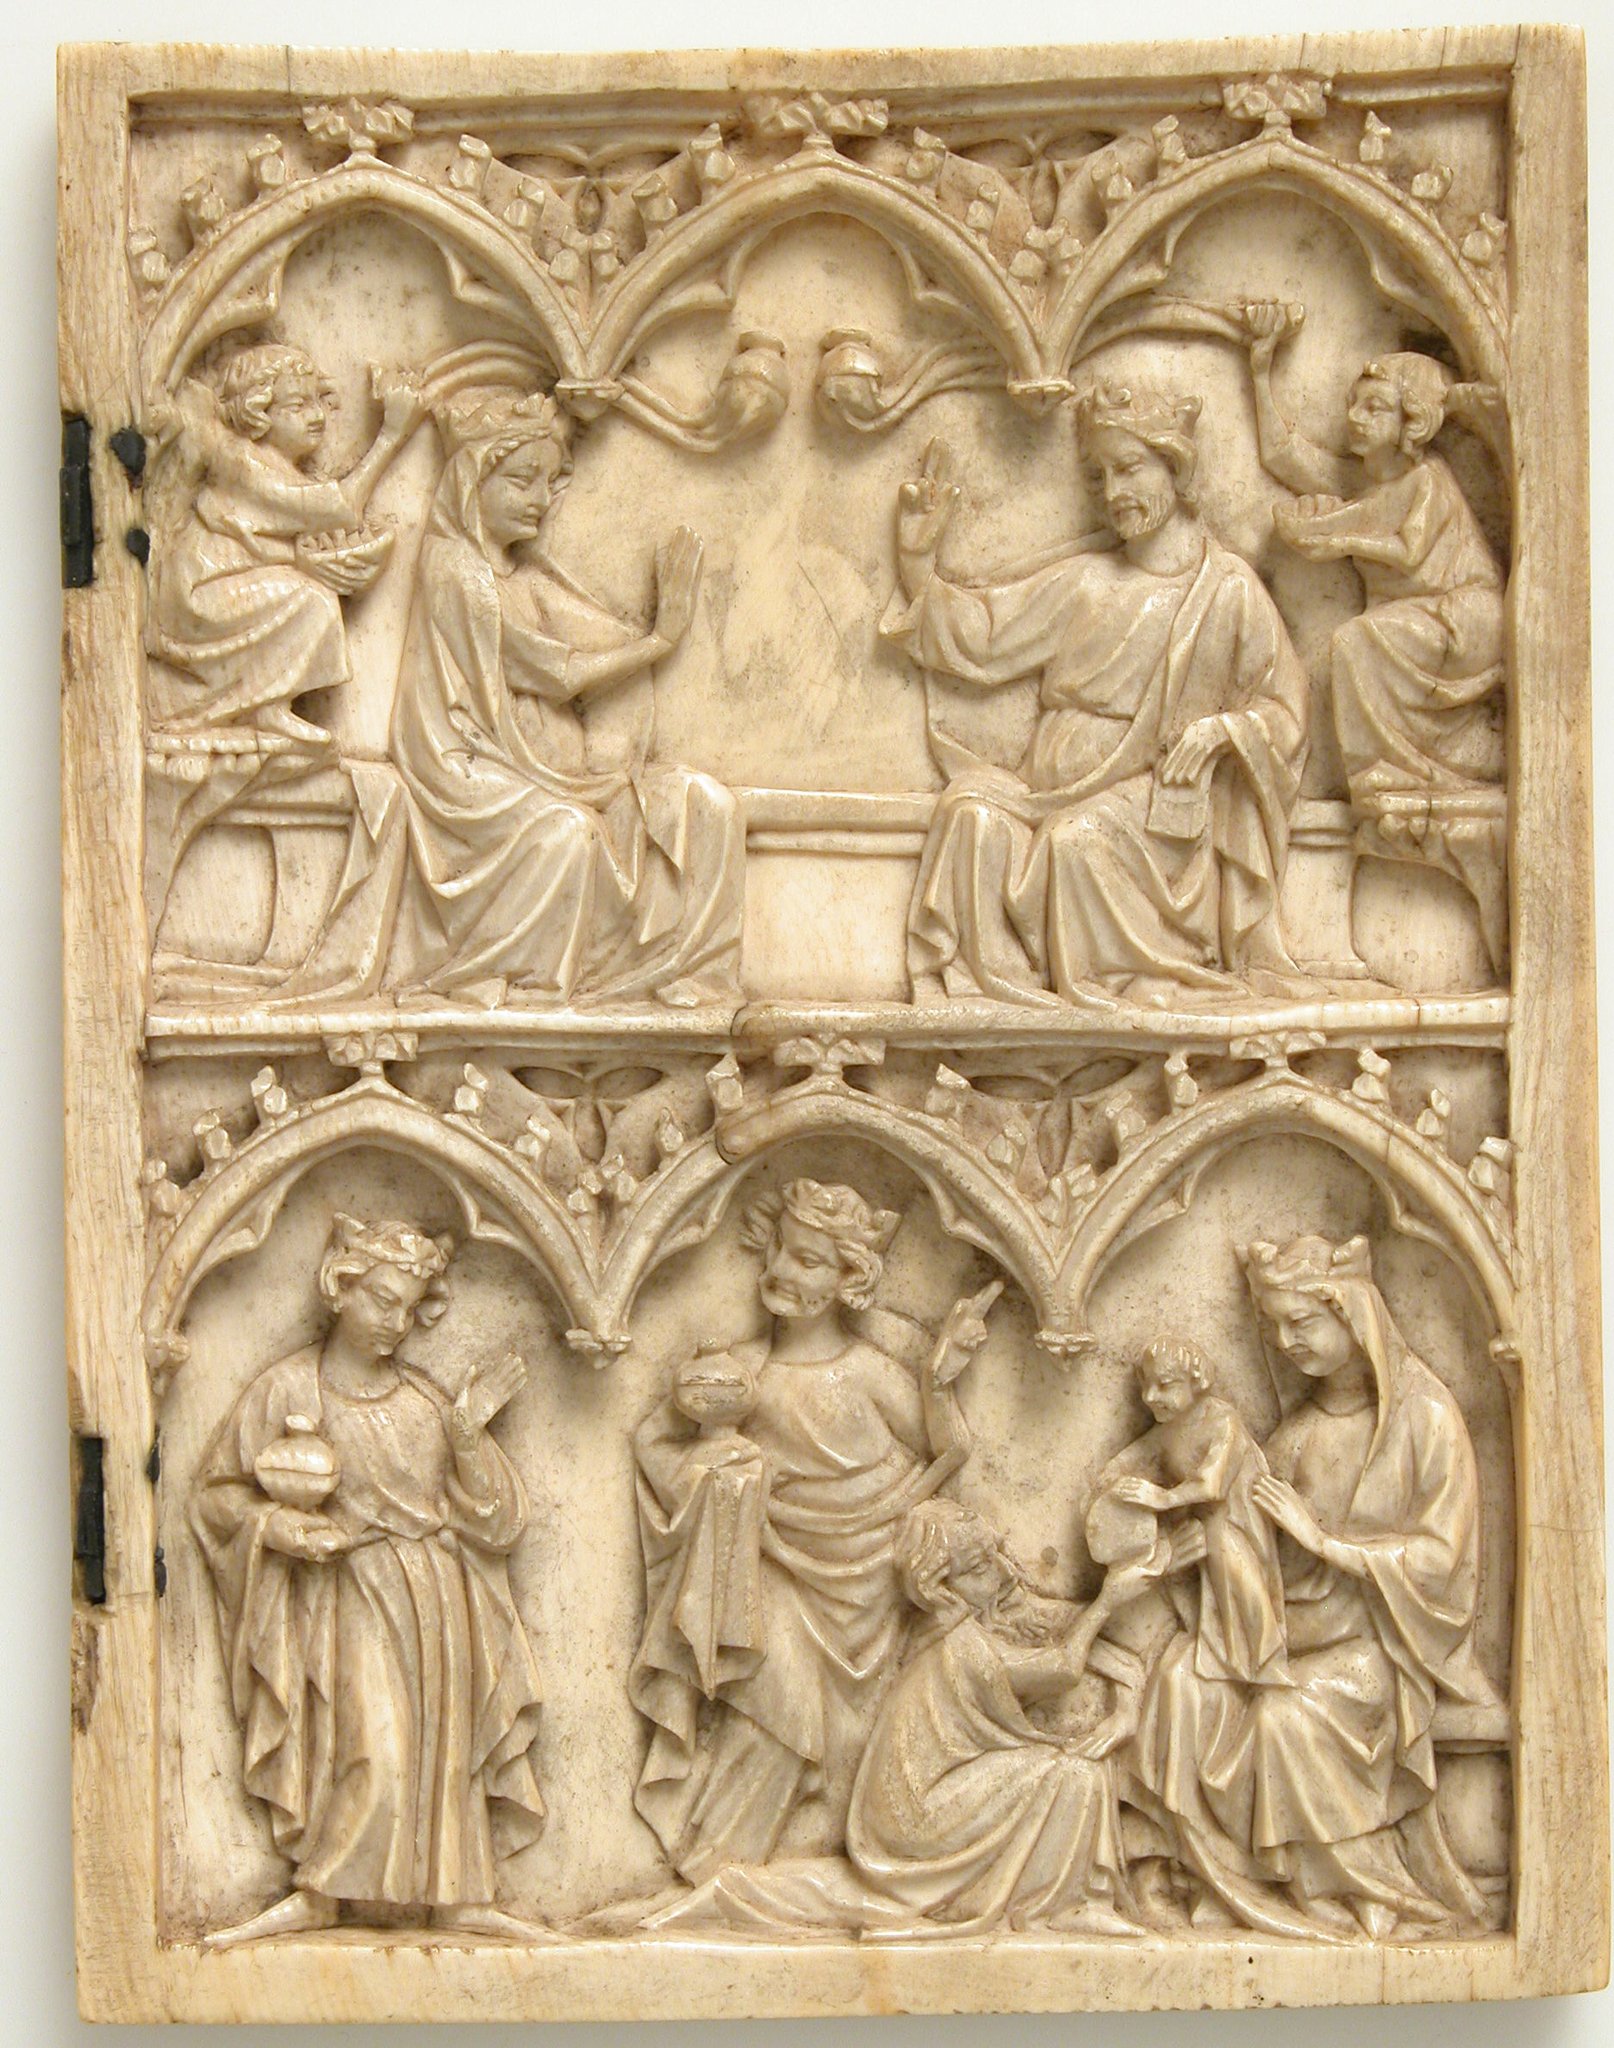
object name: diptych wing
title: Right Wing of a Diptych with Coronation of the Virgin and Adoration of the Magi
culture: french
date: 1301-1400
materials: ivory, metal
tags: angels,virgin mary,jesus,adoration of the magi